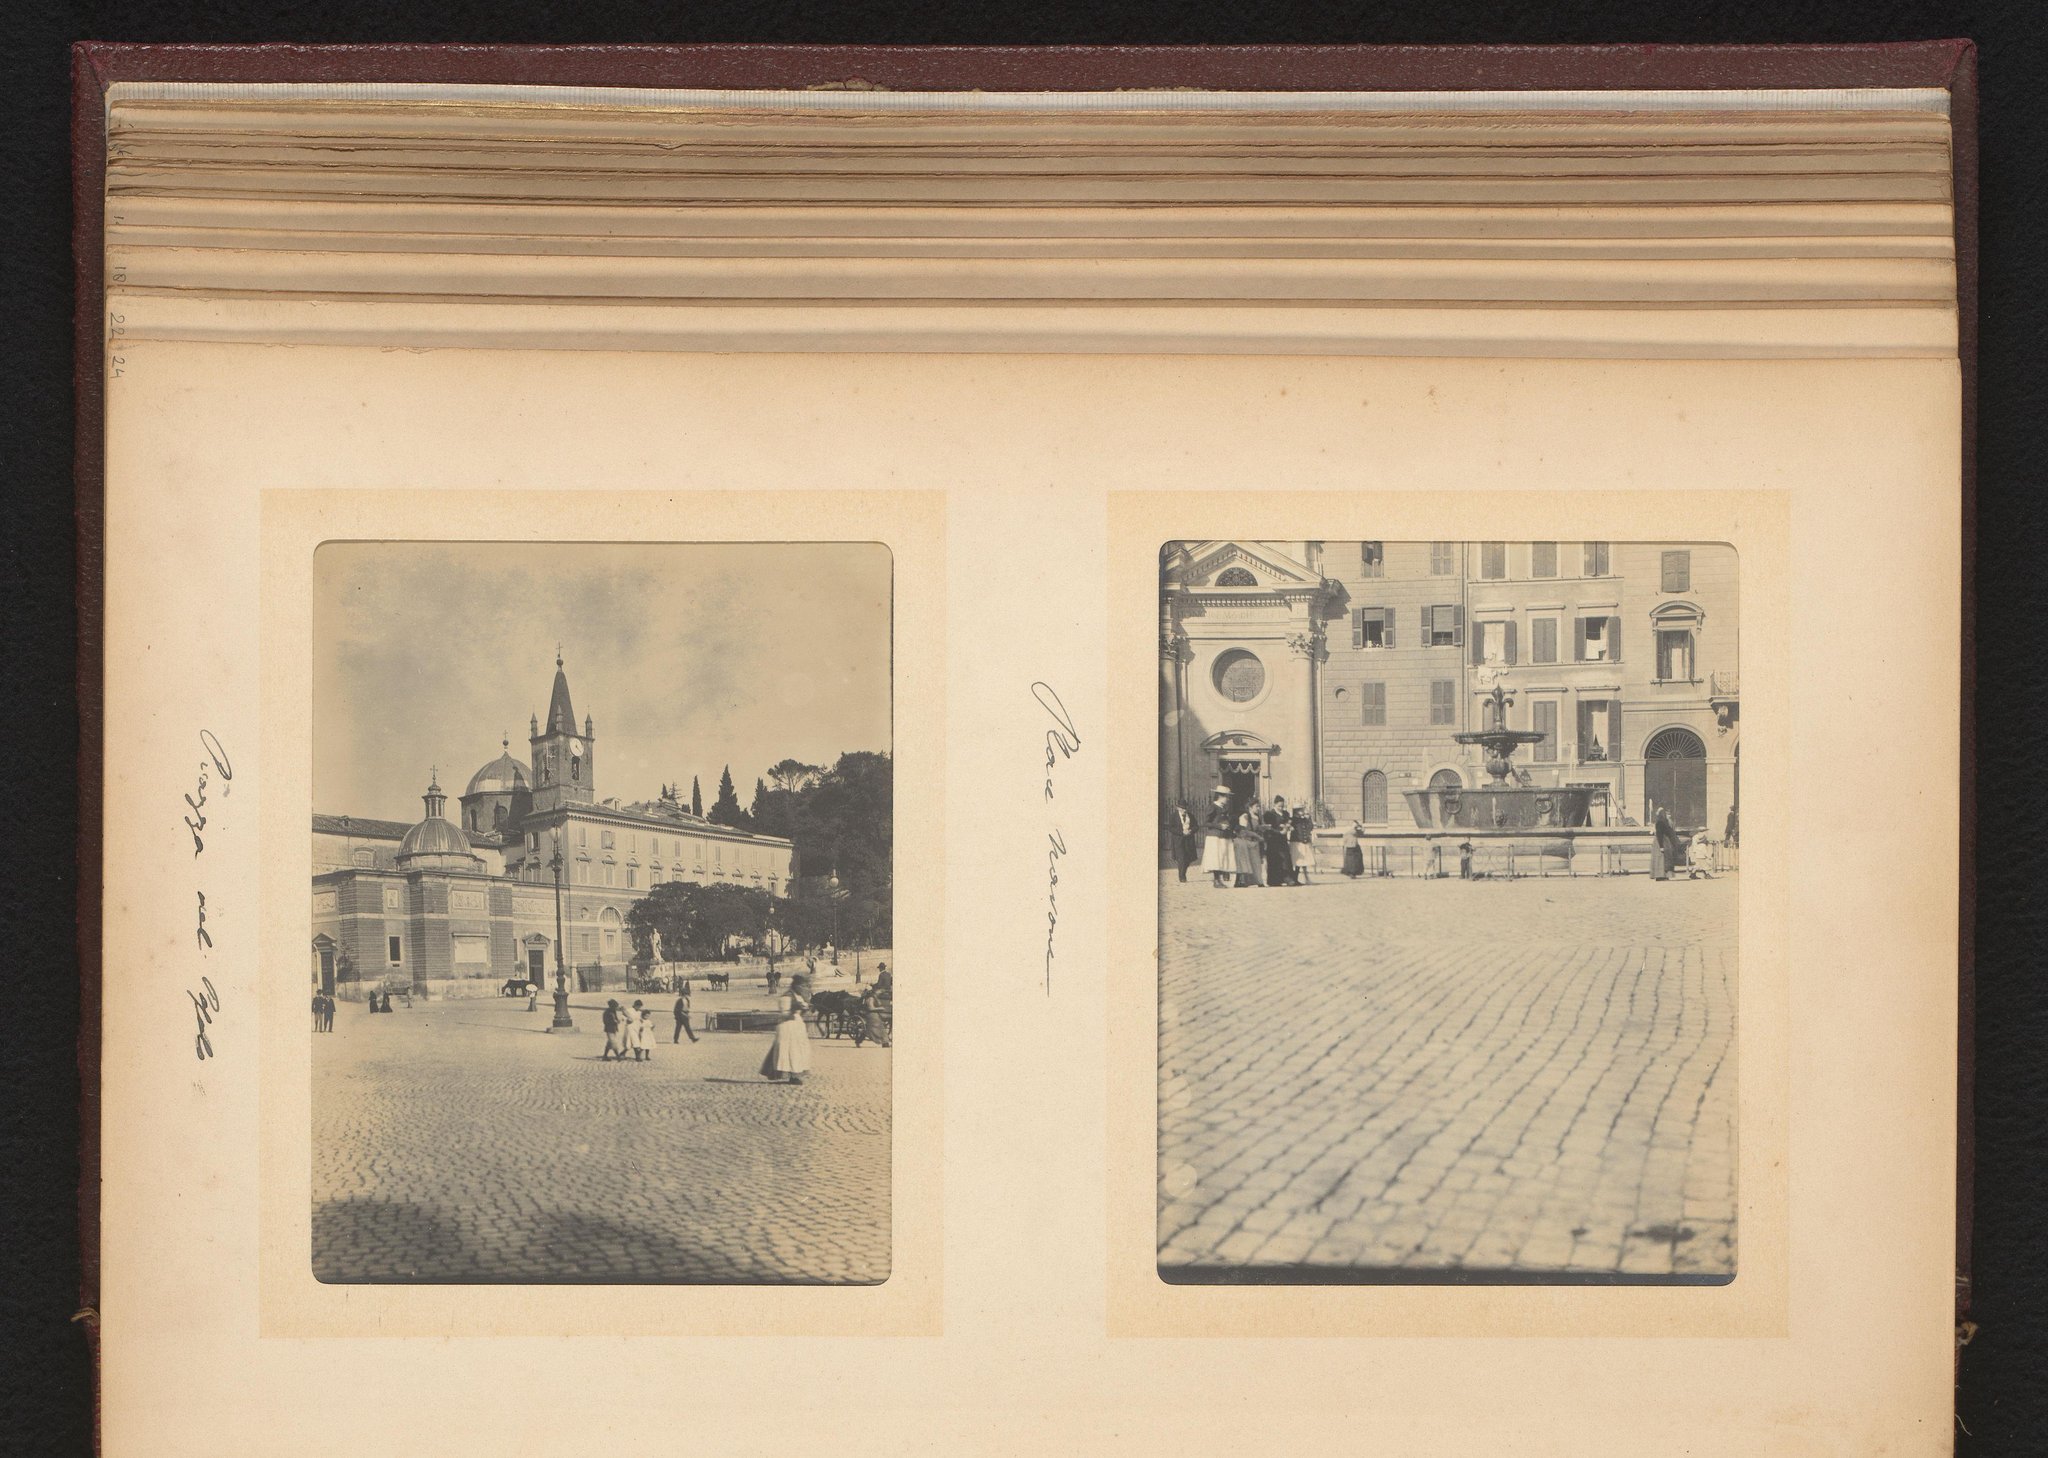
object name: photograph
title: Piazza Navona en Piazza del Popolo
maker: Anonymous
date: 1895-1905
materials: cardboard, photographic support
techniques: gelatin silver print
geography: rome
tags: tourism, square, place, circus, etc. (+ city(-scape) with figures, staffage), rome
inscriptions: inscription: ‘Place Navone / Piazza del Populo’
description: Albumblad met twee foto's in Rome. Onderdeel van een fotoalbum van een reis door Italië, ca. 1900.